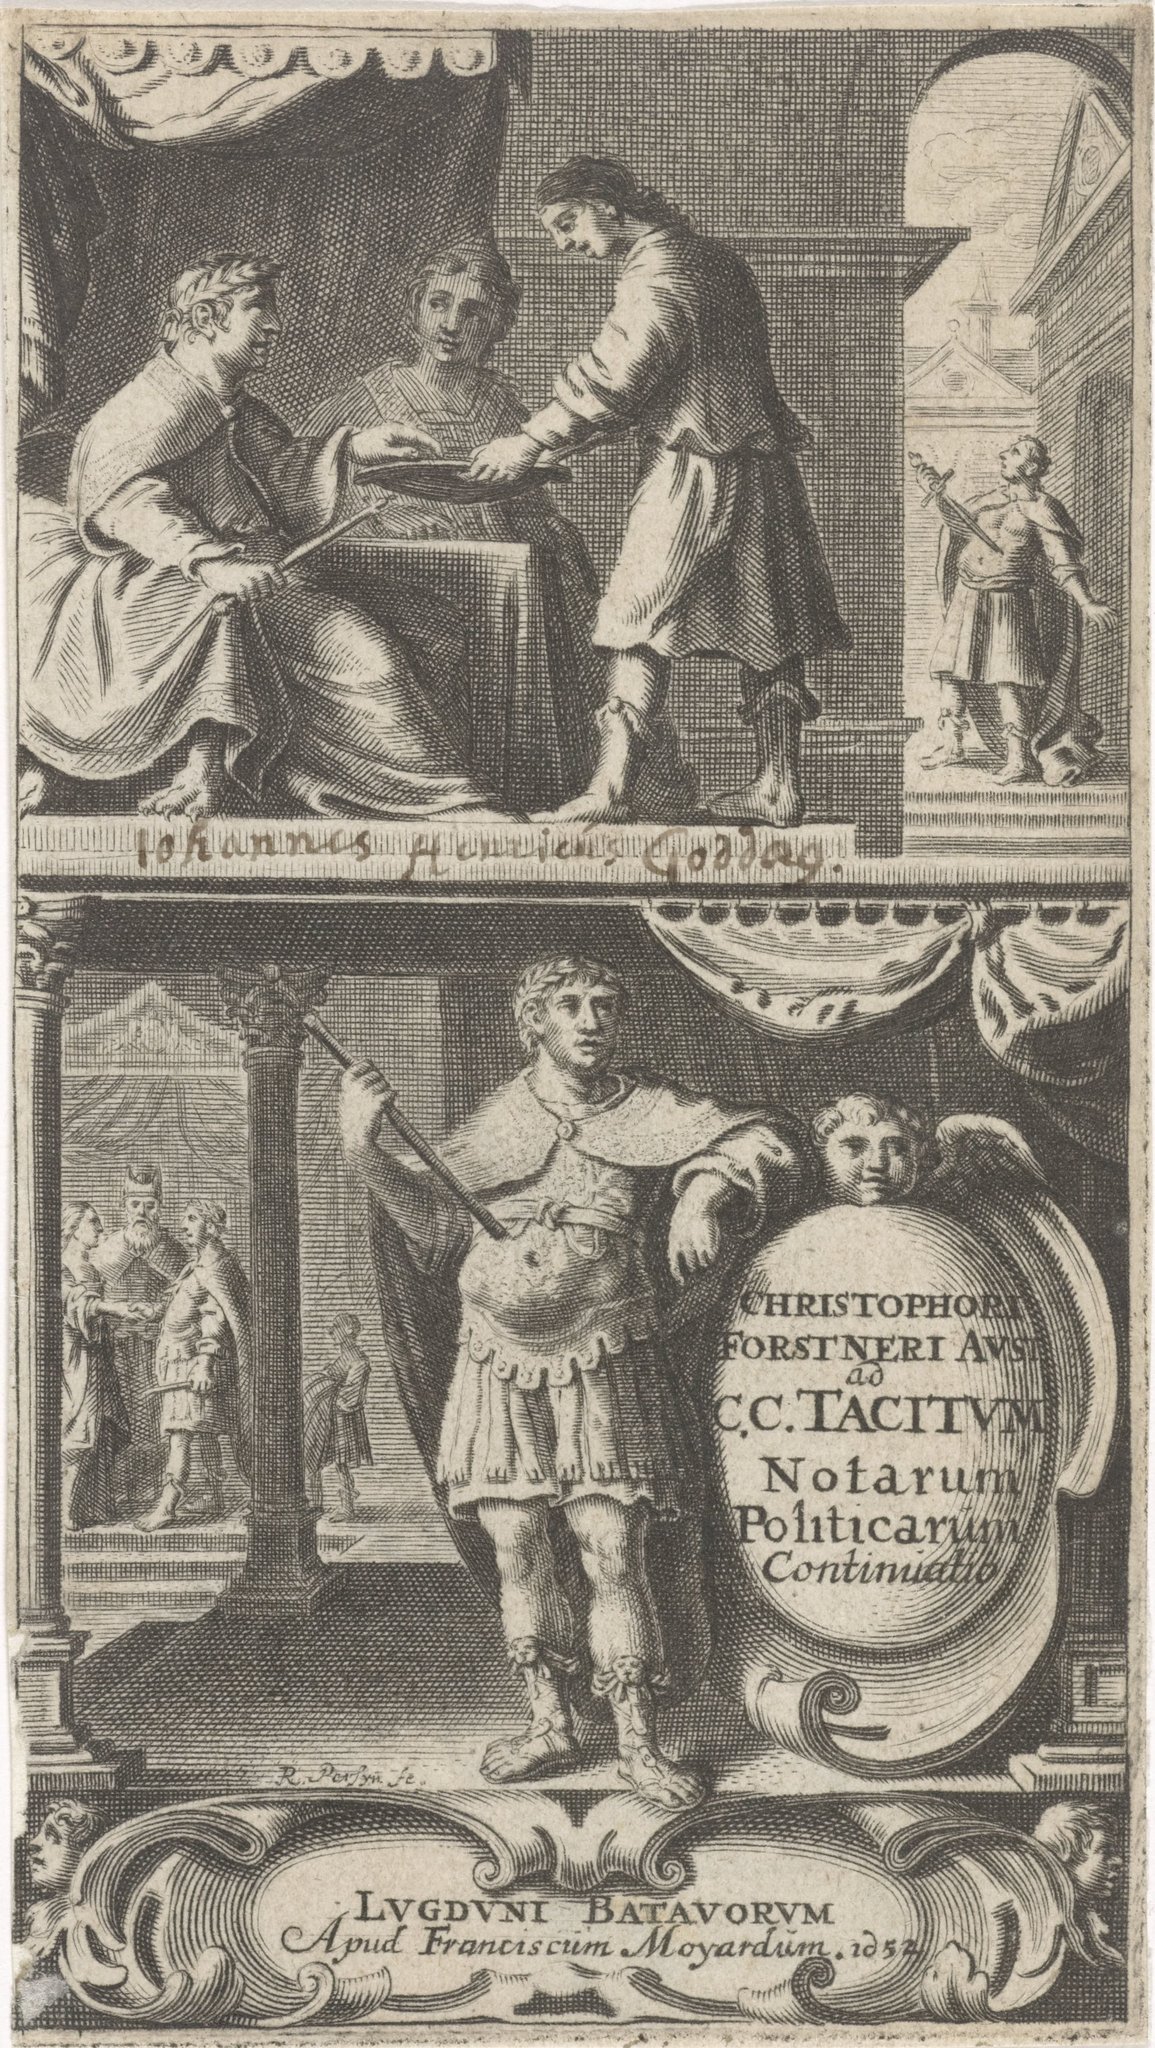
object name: print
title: Titelpagina voor: C. Forstner, C. Cornelii Taciti, notæ politicæ, Que sunt Continuatio, 1652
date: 1652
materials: paper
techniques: engraving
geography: leiden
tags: emperor, seeking death, suicide, (civil) marriage ceremonies, house personnel, servants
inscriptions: collector's mark: Lugt 2228, inscription: ‘Iohannes Henricus Goddag’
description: Een keizer leunt op een cartouche waarop de titel in het Latijn. Op de achtergrond wordt een huwelijk gesloten. Bovenaan een bediende die de keizer en zijn echtgenote een schaal aanbiedt. Op de achtergrond een soldaat die zichzelf met zijn zwaard neersteekt. Onderaan in een cartouche een impressum in het Latijn.